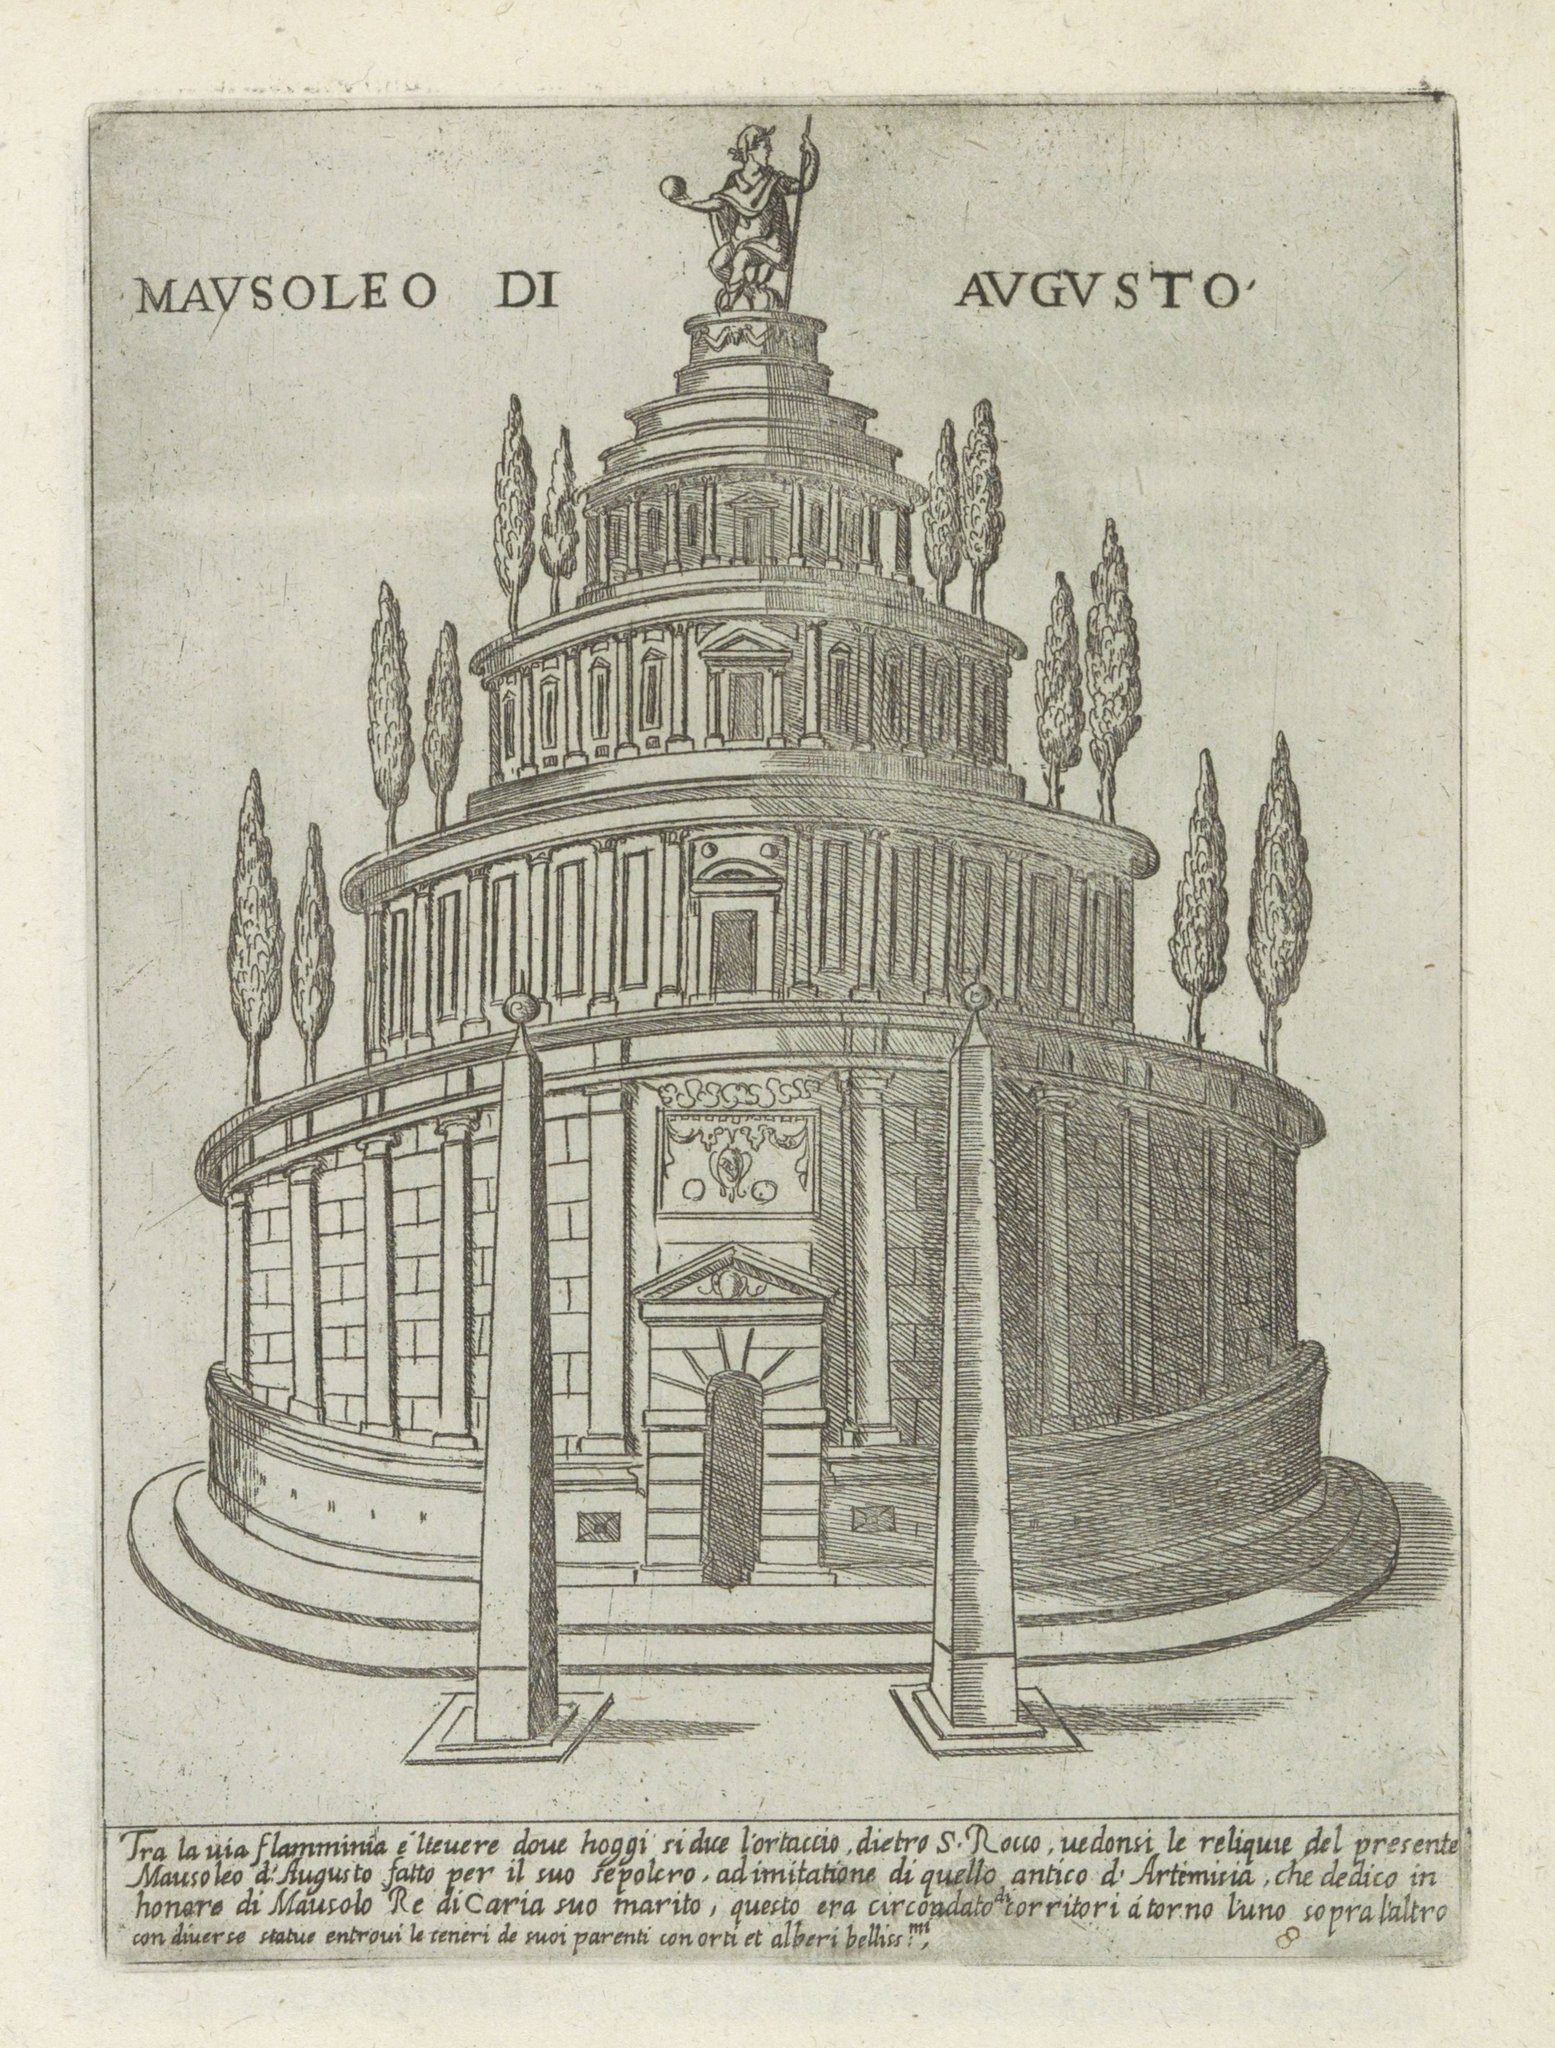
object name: album leaf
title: Mausoleum van Augustus te Rome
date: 1576-1618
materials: paper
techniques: etching, intaglio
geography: italy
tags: mausoleum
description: Tekst in het Italiaans onder de voorstelling. De prent maakt deel uit van een album.